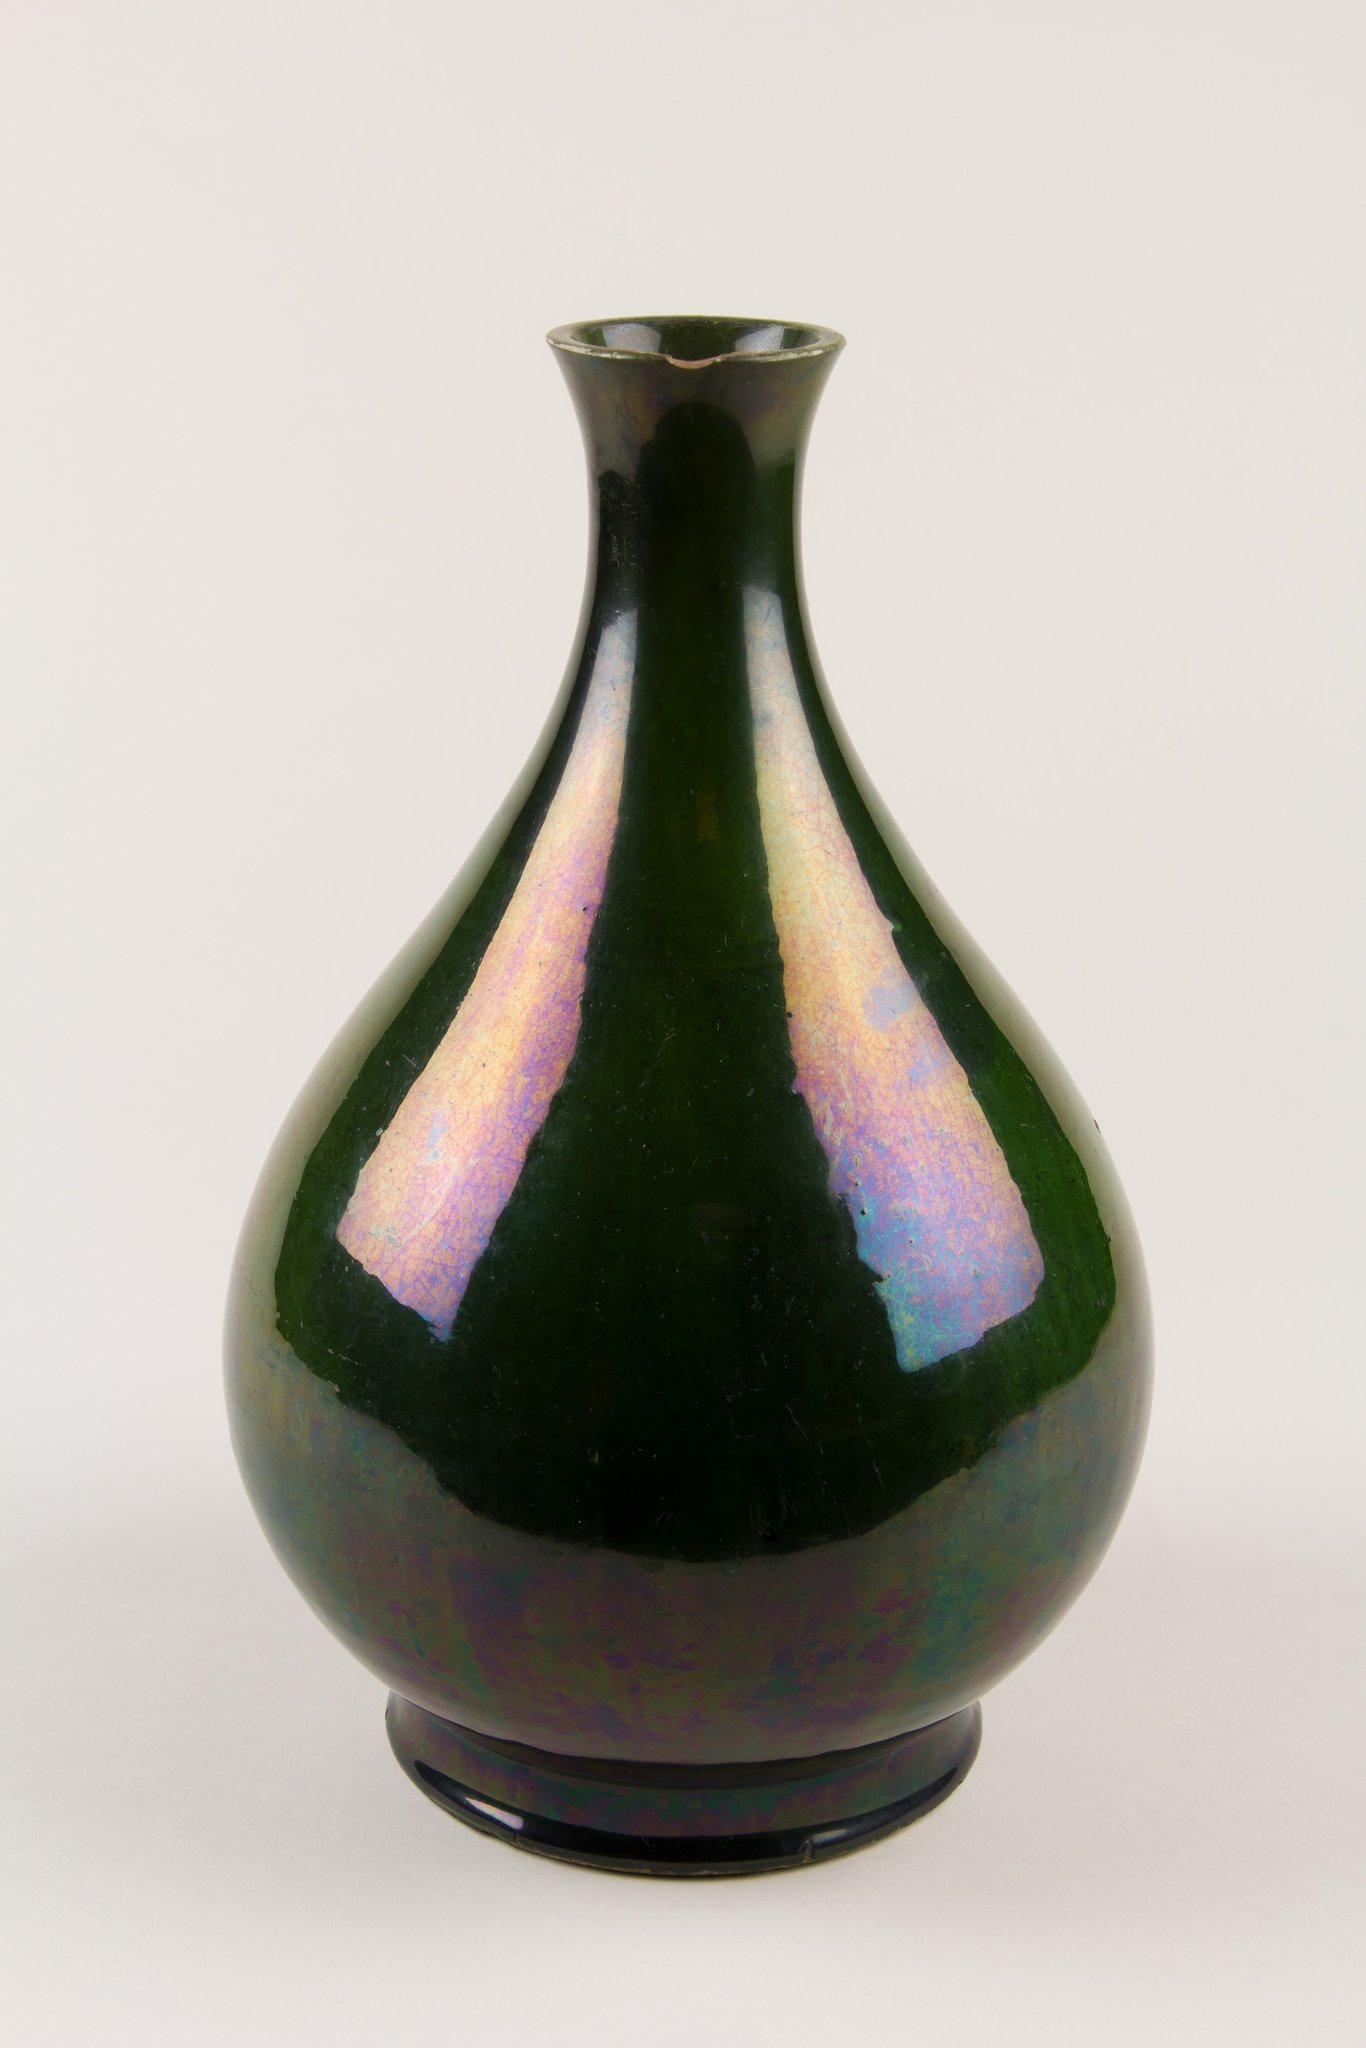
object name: vase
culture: chinese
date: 1801-1900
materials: glaze, porcelain